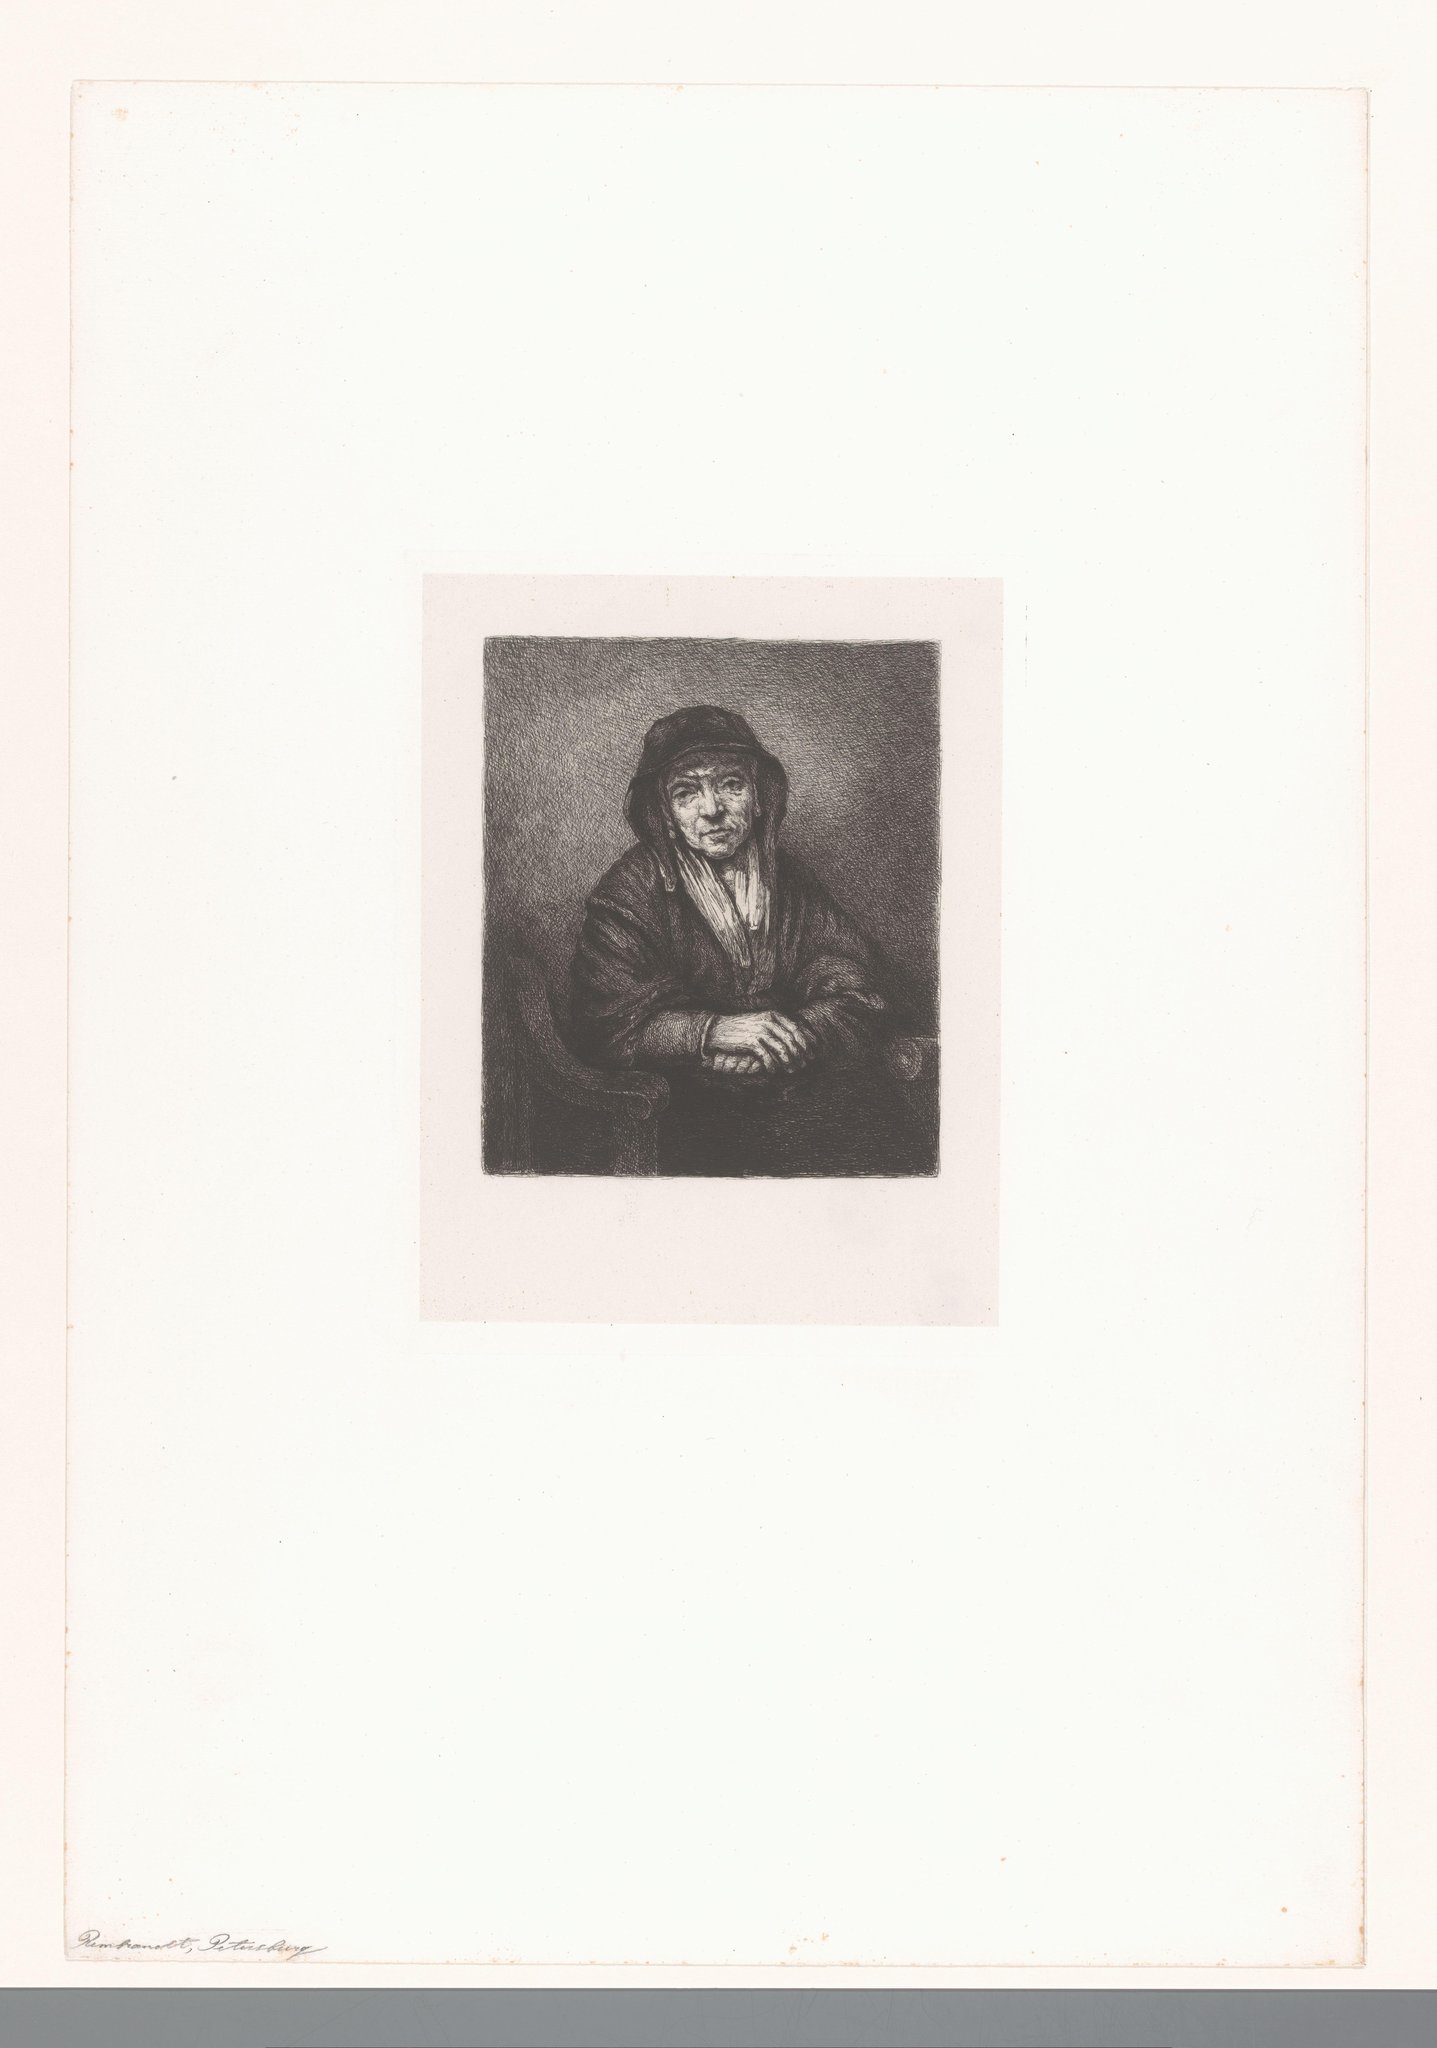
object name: print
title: Portret van een onbekende oude vrouw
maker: nikolay semyonovich mosolov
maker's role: print maker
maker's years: 1847-1914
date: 1857-1914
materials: paper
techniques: drypoint, etching, intaglio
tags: anonymous historical person portrayed alone - bb - woman